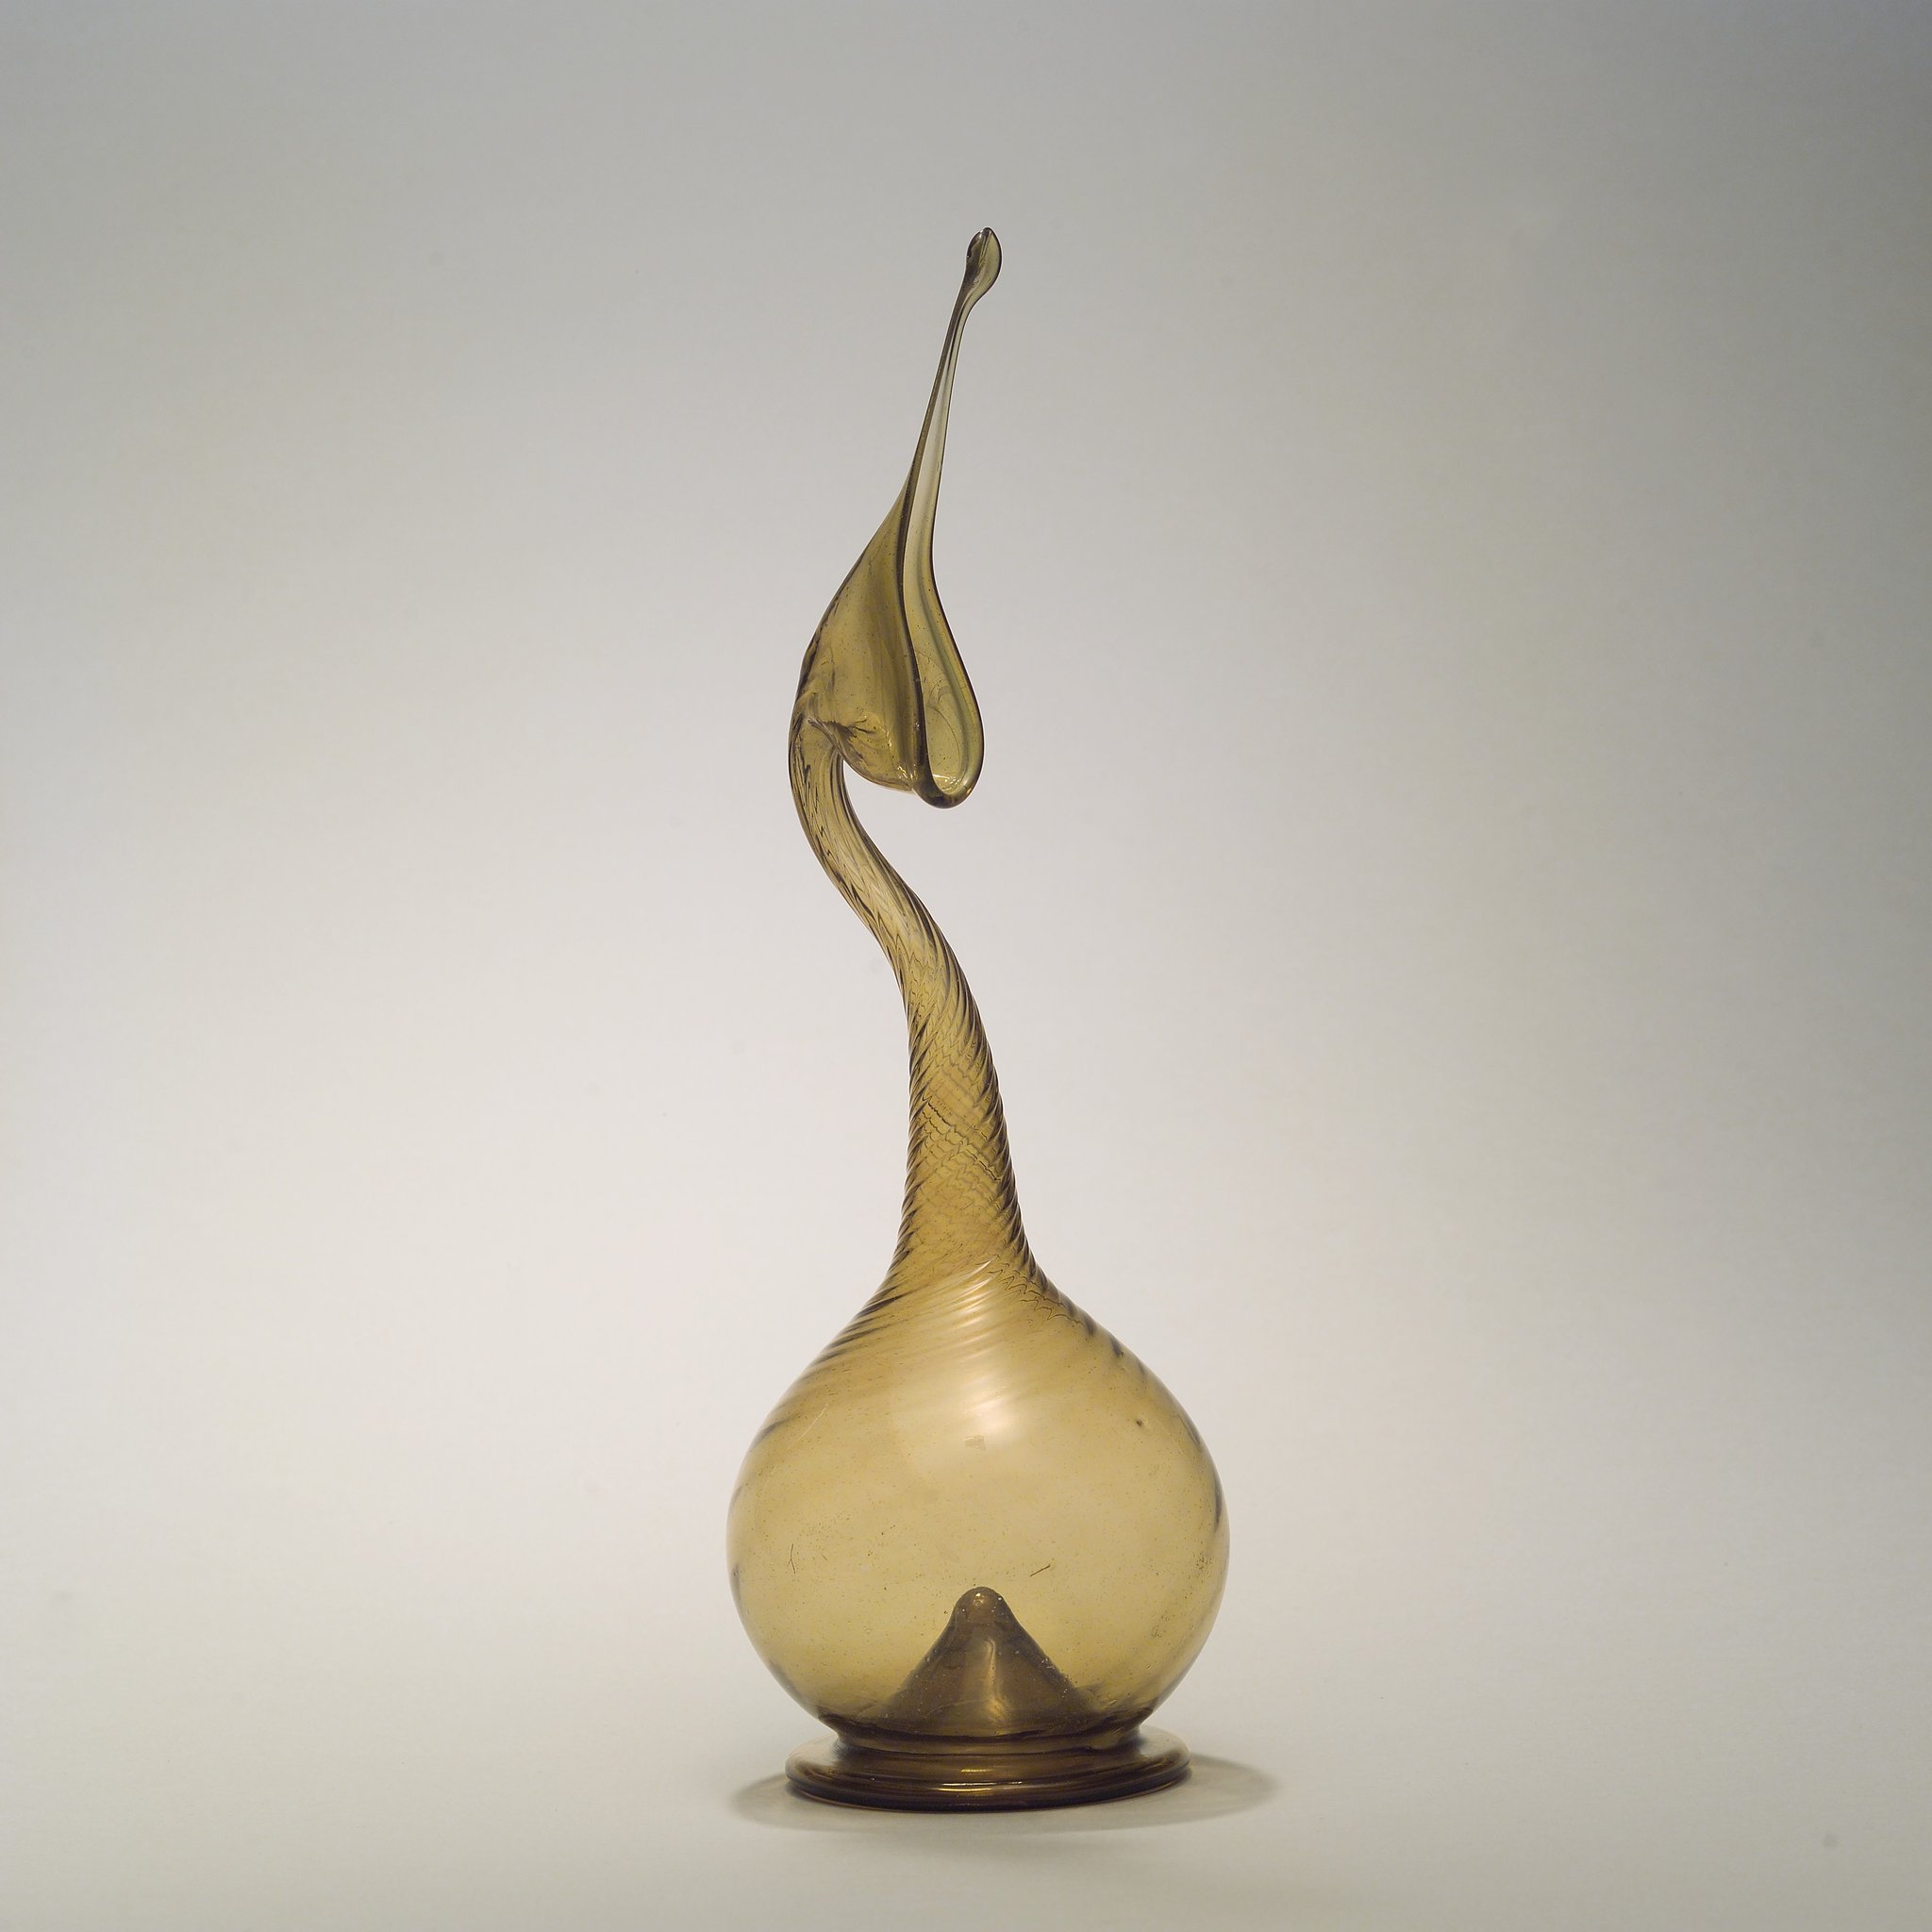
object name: bottle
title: Swan-Neck Bottle (Ashkdan)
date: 1801-1900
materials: glass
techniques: glassblowing, molding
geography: iran